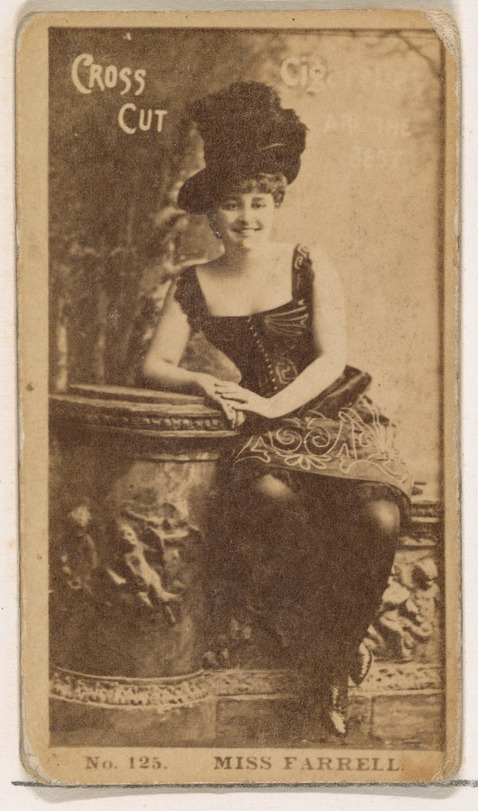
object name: print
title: Card Number 125, Miss Farrell, from the Actors and Actresses series (N145-2) issued by Duke Sons & Co. to promote Cross Cut Cigarettes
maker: w. duke, sons & co.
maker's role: publisher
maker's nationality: american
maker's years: 1870-1920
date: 1880-1889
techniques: albumen silver print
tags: portraits,women,actresses